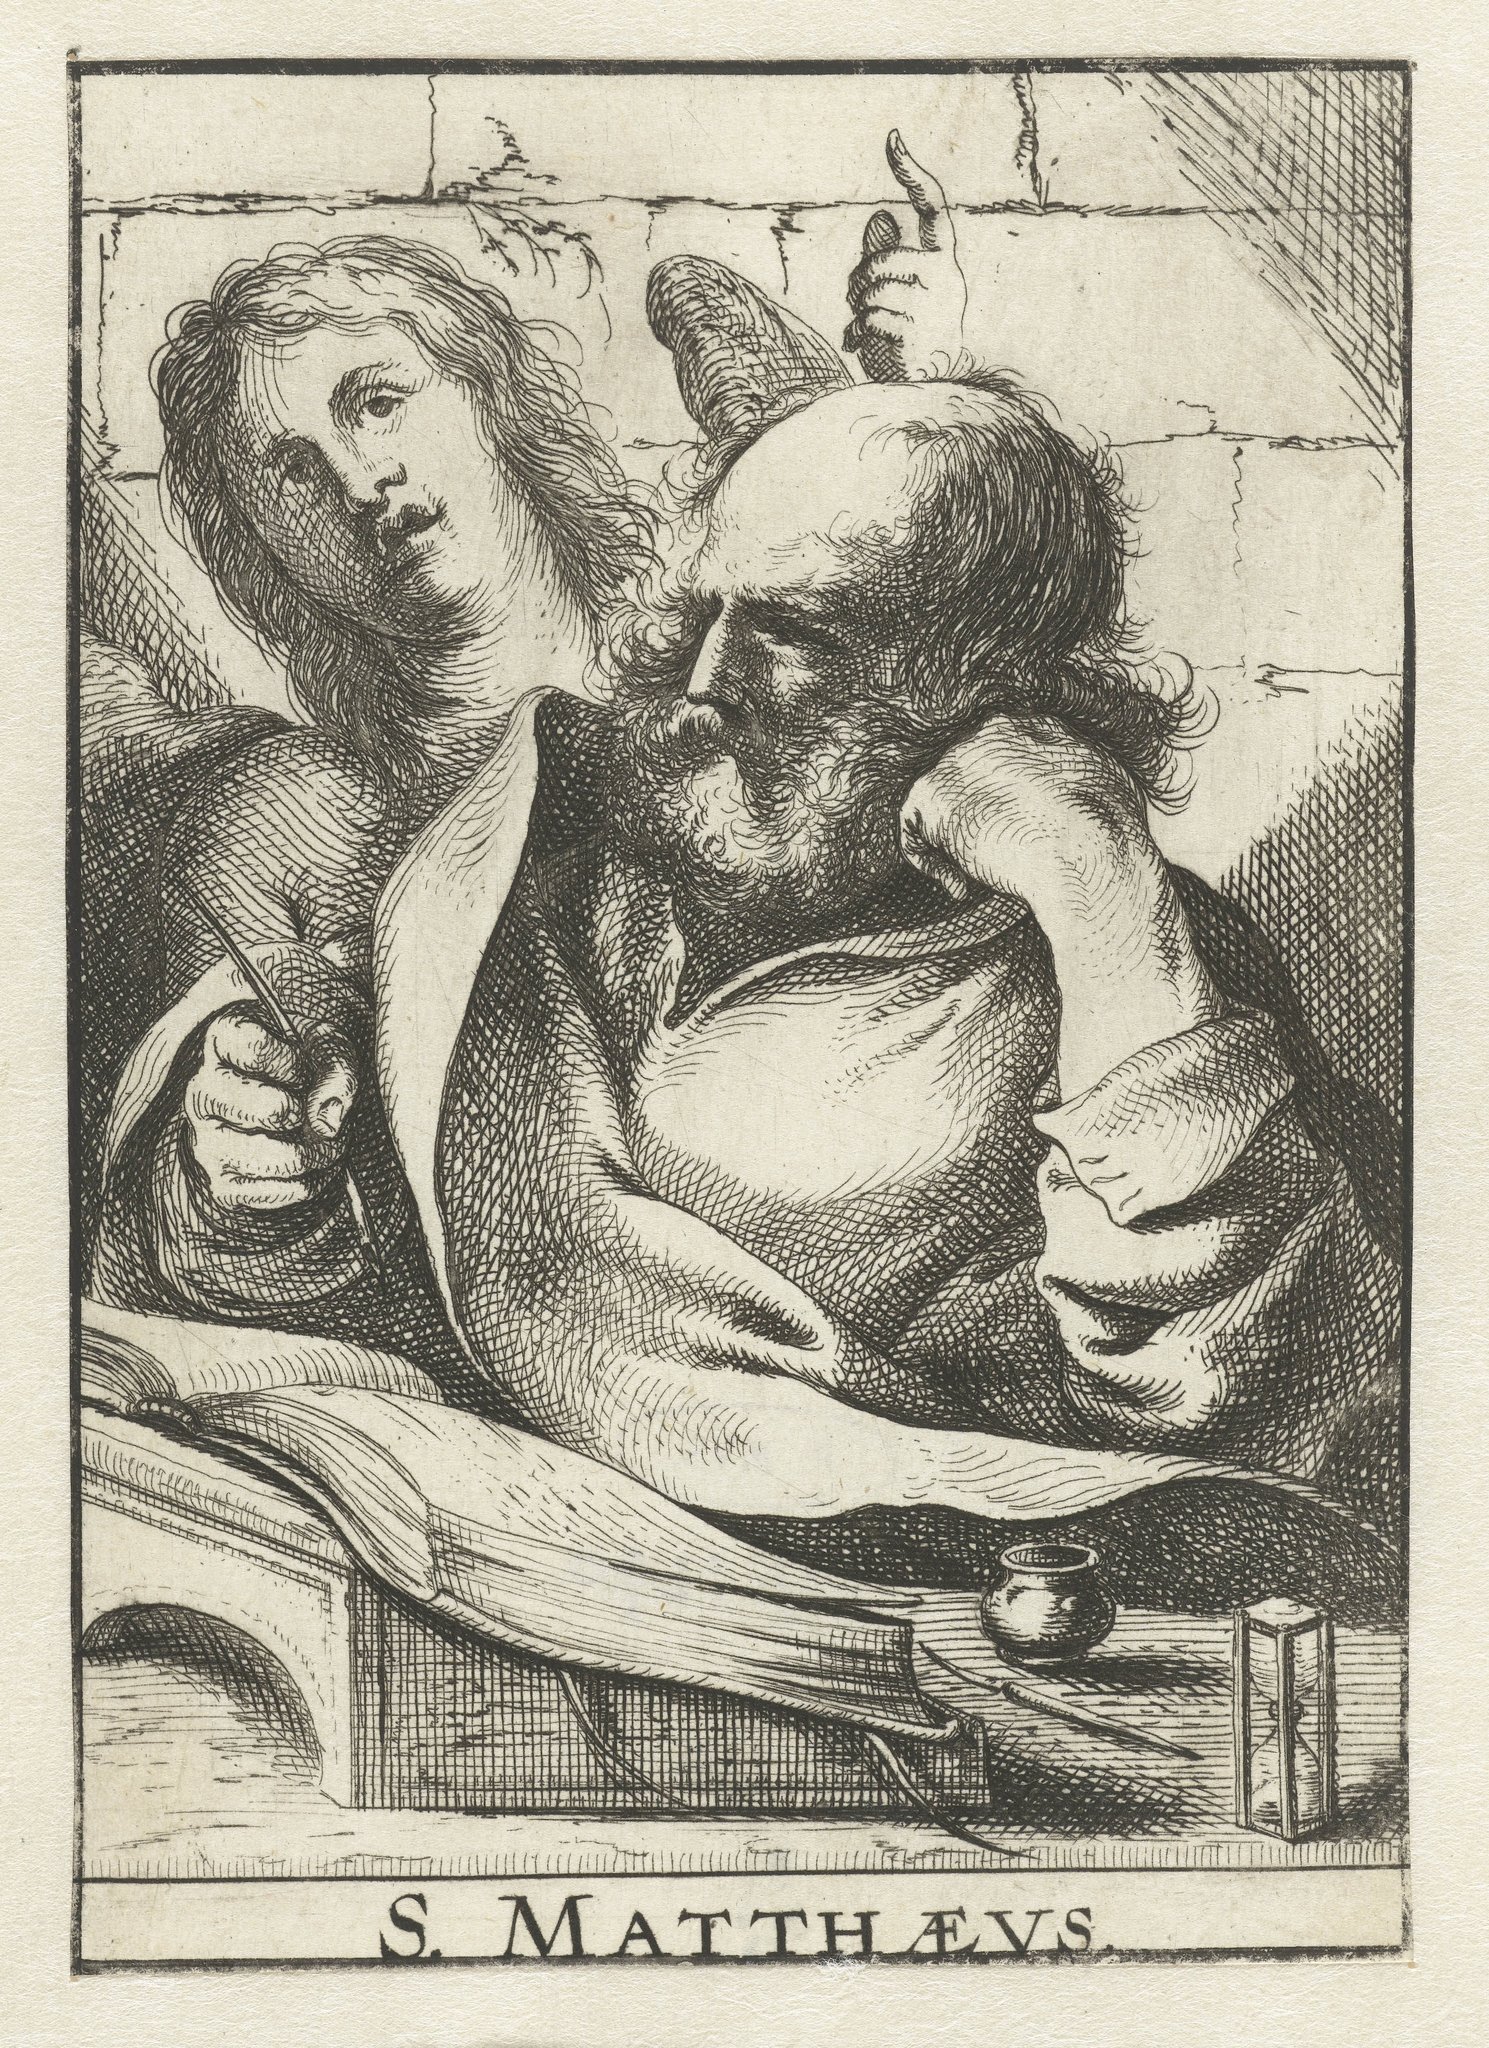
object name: print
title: S. Matthaevs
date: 1625-1674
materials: paper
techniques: engraving, etching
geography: antwerp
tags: the apostle and evangelist matthew (mattheus); possible attributes: angel, axe, book, halberd, pen and inkhorn, purse, scroll, square, sword, angel (possibly with book) ~ symbol of st. matthew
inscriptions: collector's mark: Lugt 2228a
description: De evangelist Matteüs met zijn attribuut de engel